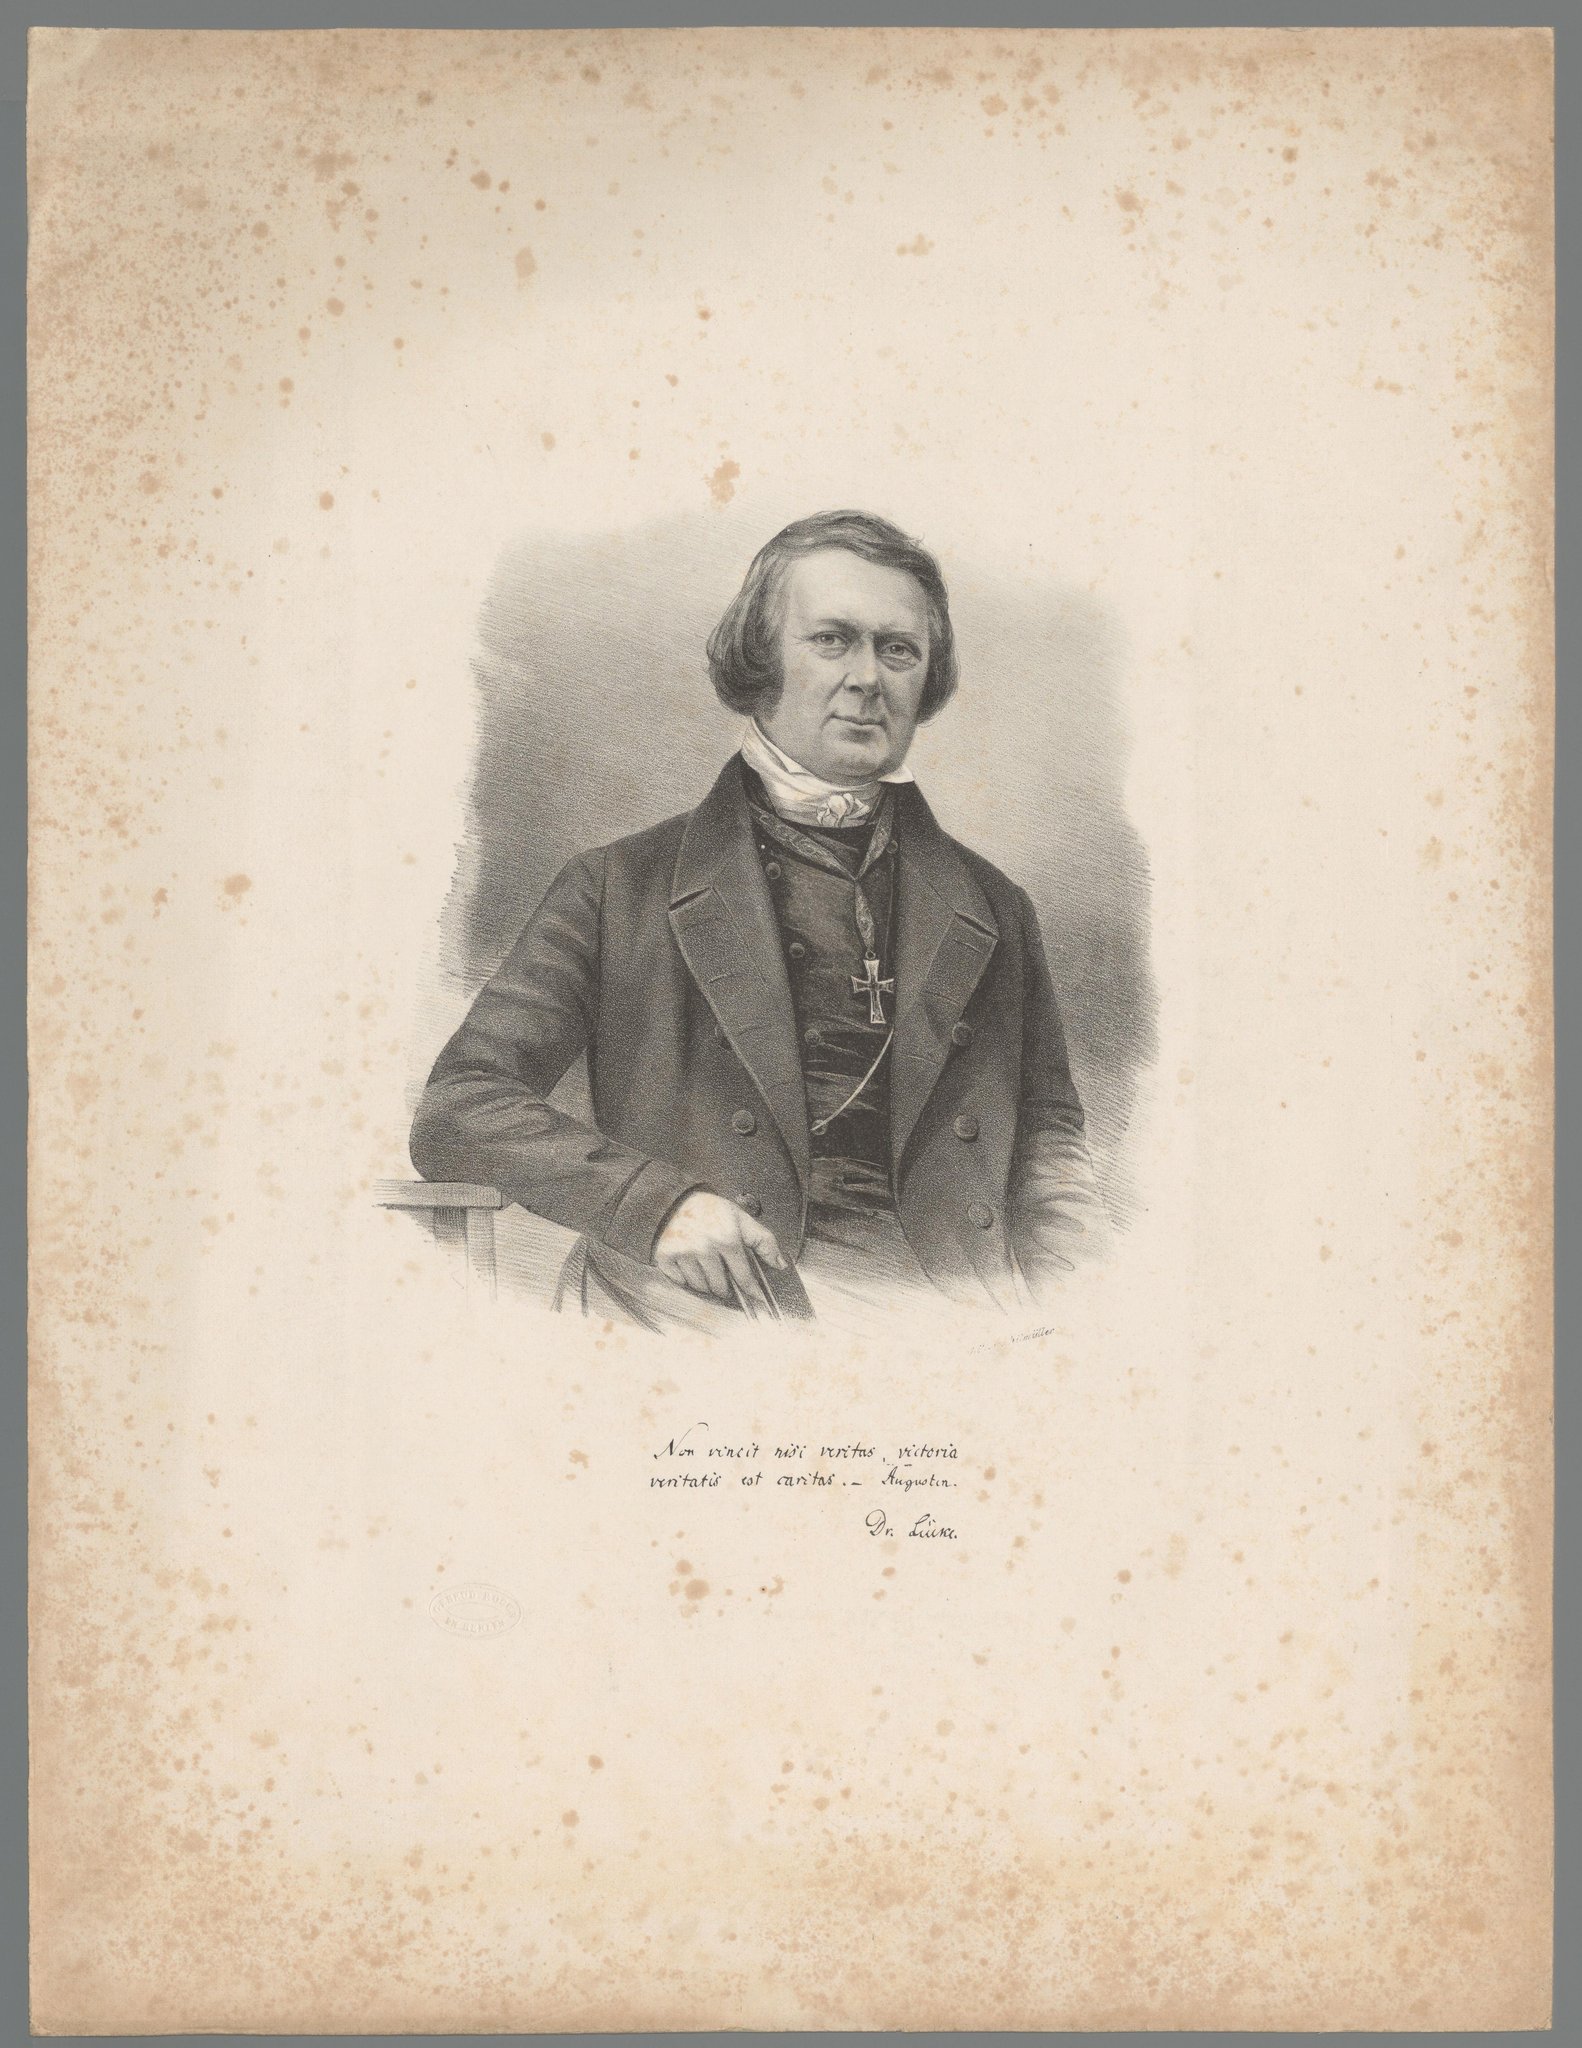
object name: print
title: Portret van een onbekende man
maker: friedrich eduard ritmüller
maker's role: printer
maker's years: 1805-1869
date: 1830-1863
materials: paper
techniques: lithograph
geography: berlin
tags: historical persons not known by name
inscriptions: collector's mark: Lugt 2228, check stamp: Lugt 2141c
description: Portret van een verder onbekende man, met handtekening in facsimile waarin mogelijk de naam Lücke te lezen is.